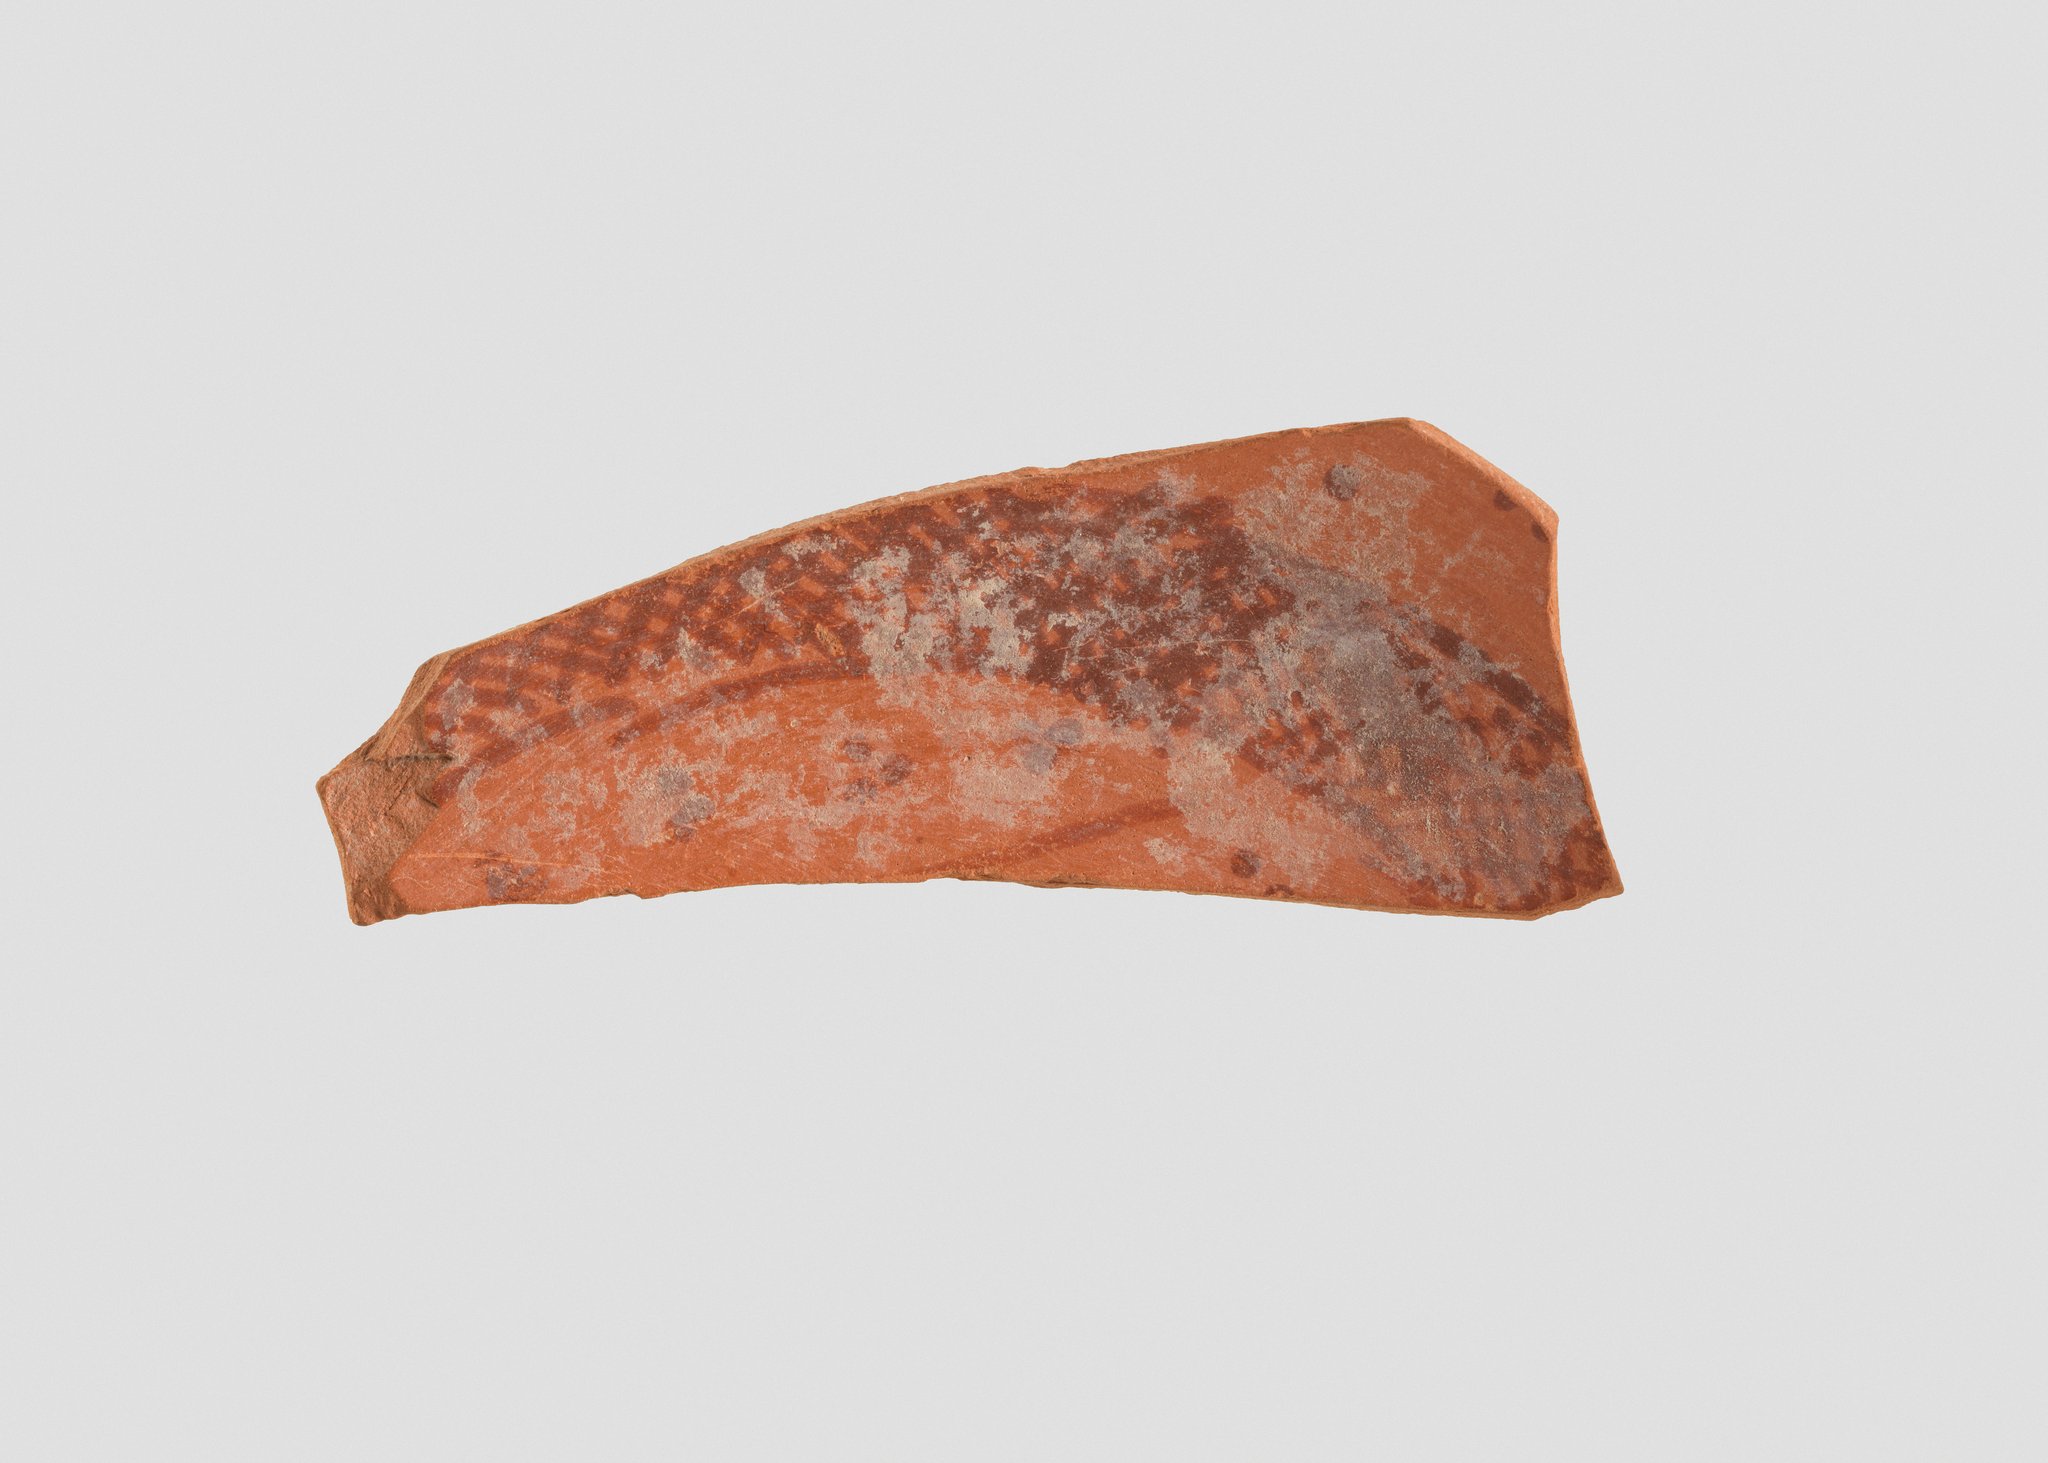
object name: sherd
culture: nabataean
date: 1-100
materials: ceramic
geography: levant